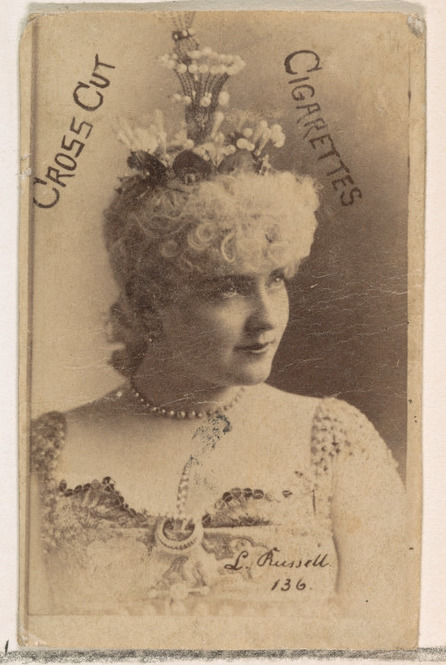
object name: print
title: Card Number 136, Lillian Russell, from the Actors and Actresses series (N145-1) issued by Duke Sons & Co. to promote Cross Cut Cigarettes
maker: w. duke, sons & co.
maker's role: publisher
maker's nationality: american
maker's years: 1870-1920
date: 1880-1889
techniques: albumen silver print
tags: portraits,women,actresses